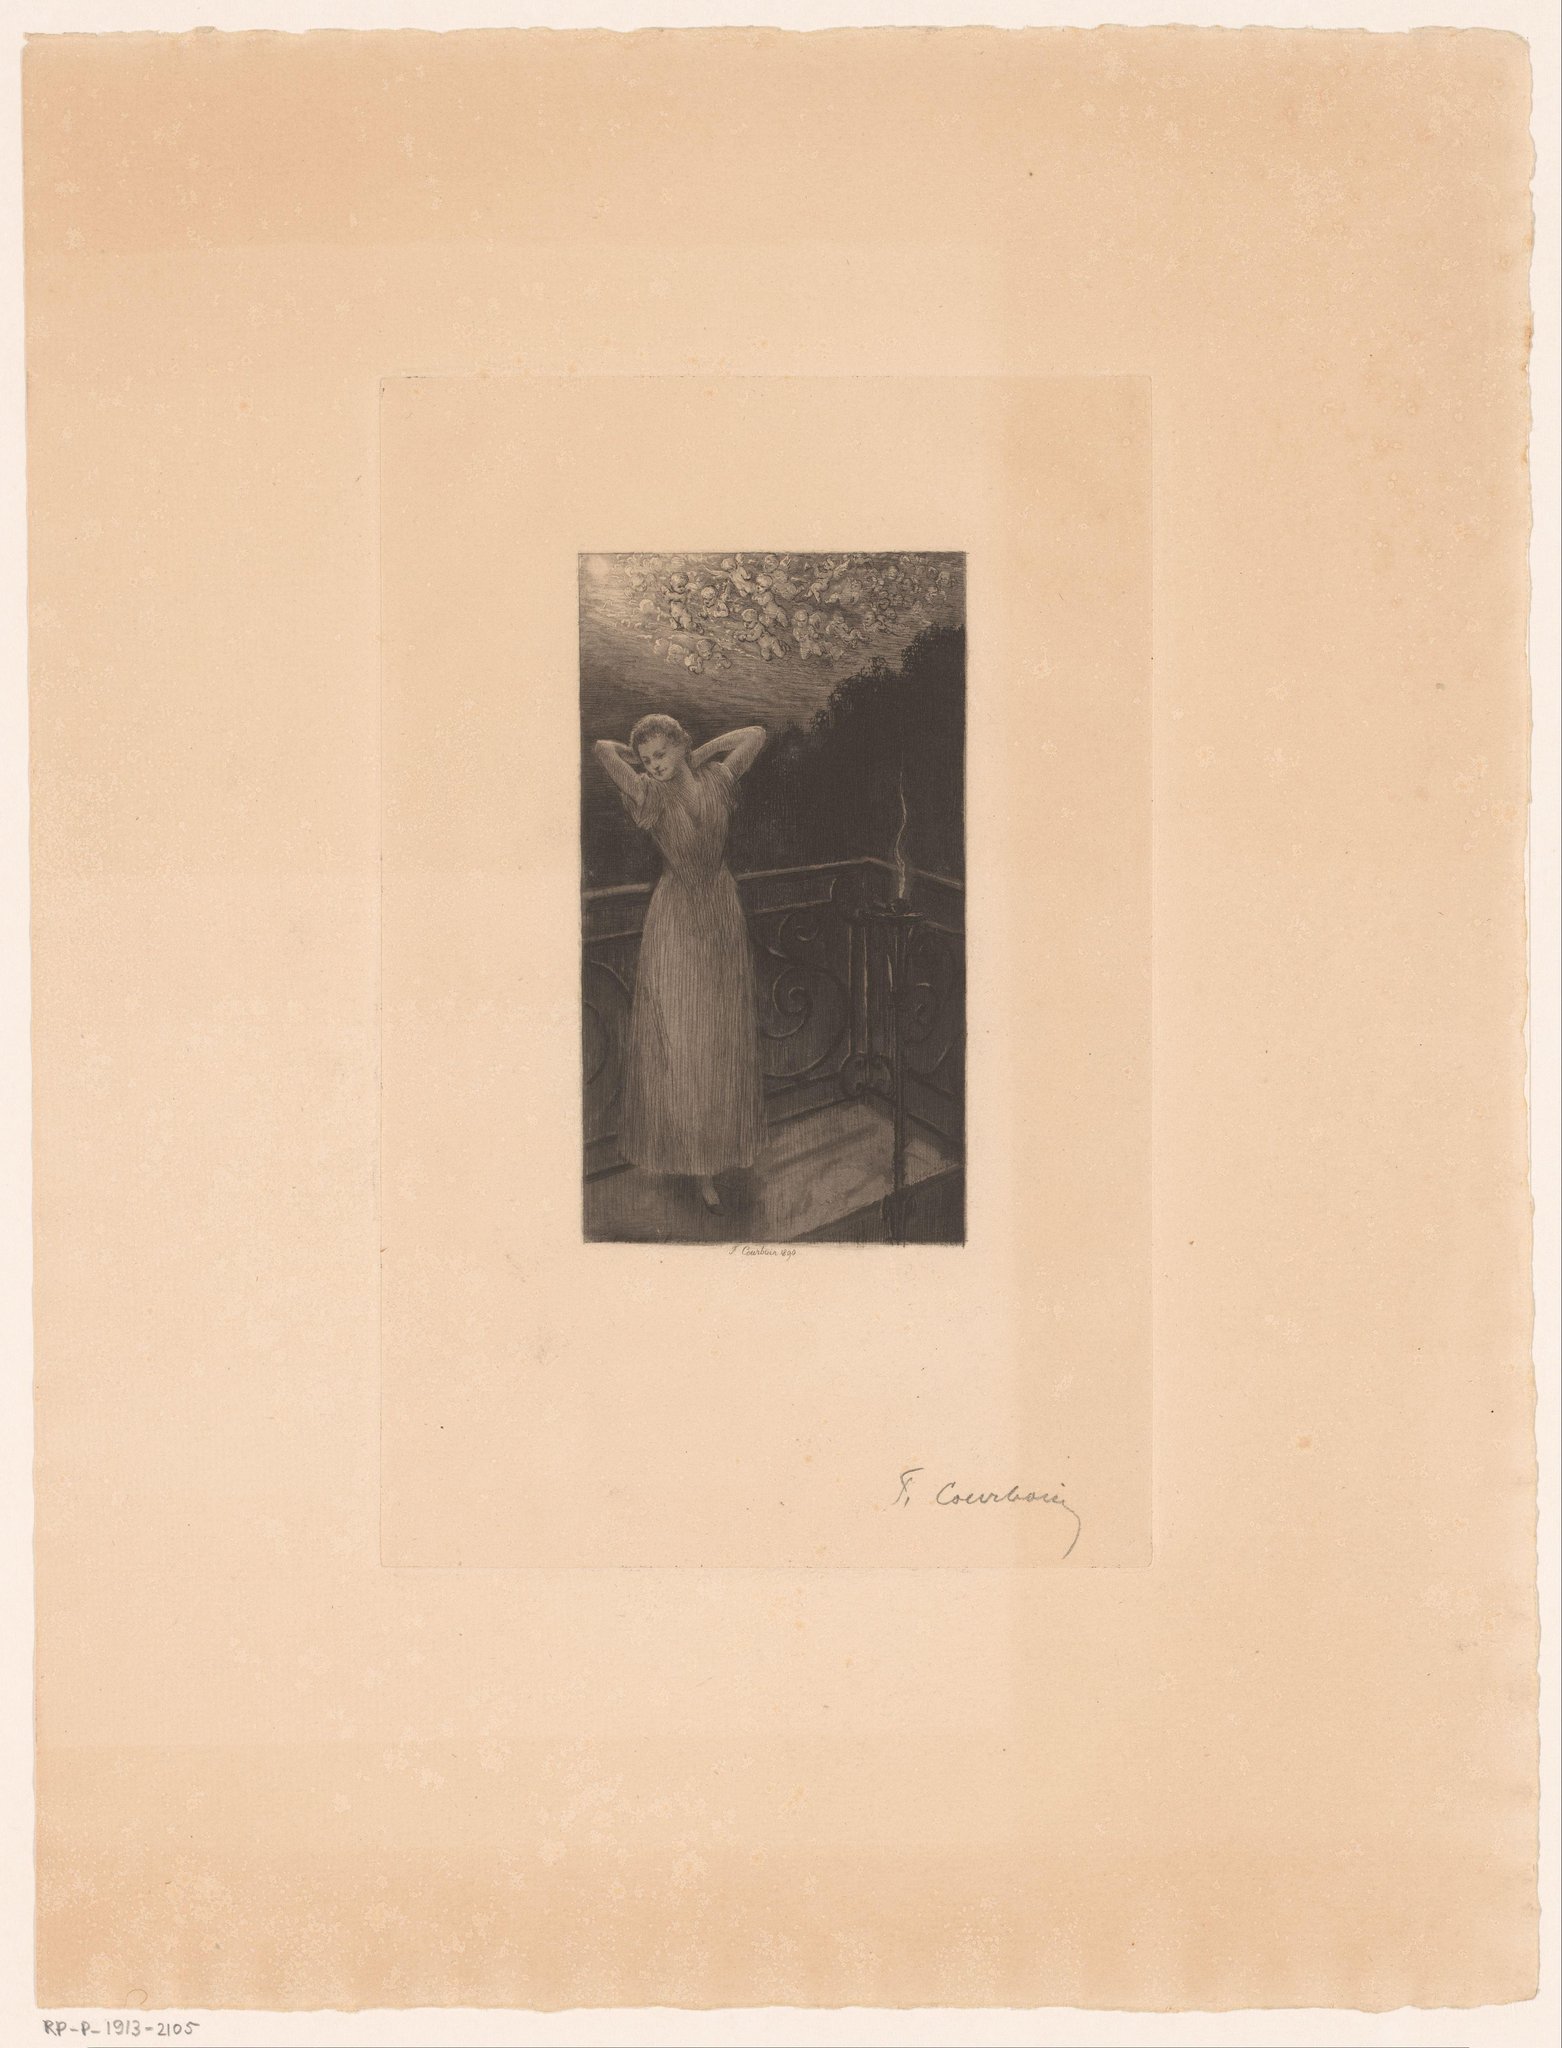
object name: print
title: Jonge vrouw op een balkon met putti in de lucht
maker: françois courboin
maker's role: print maker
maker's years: 1865-1926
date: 1890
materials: paper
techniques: aquatint, drypoint, etching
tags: adolescent, young woman, maiden, balcony, cupids: 'amores', 'amoretti', 'putti'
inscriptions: collector's mark: Lugt 2233